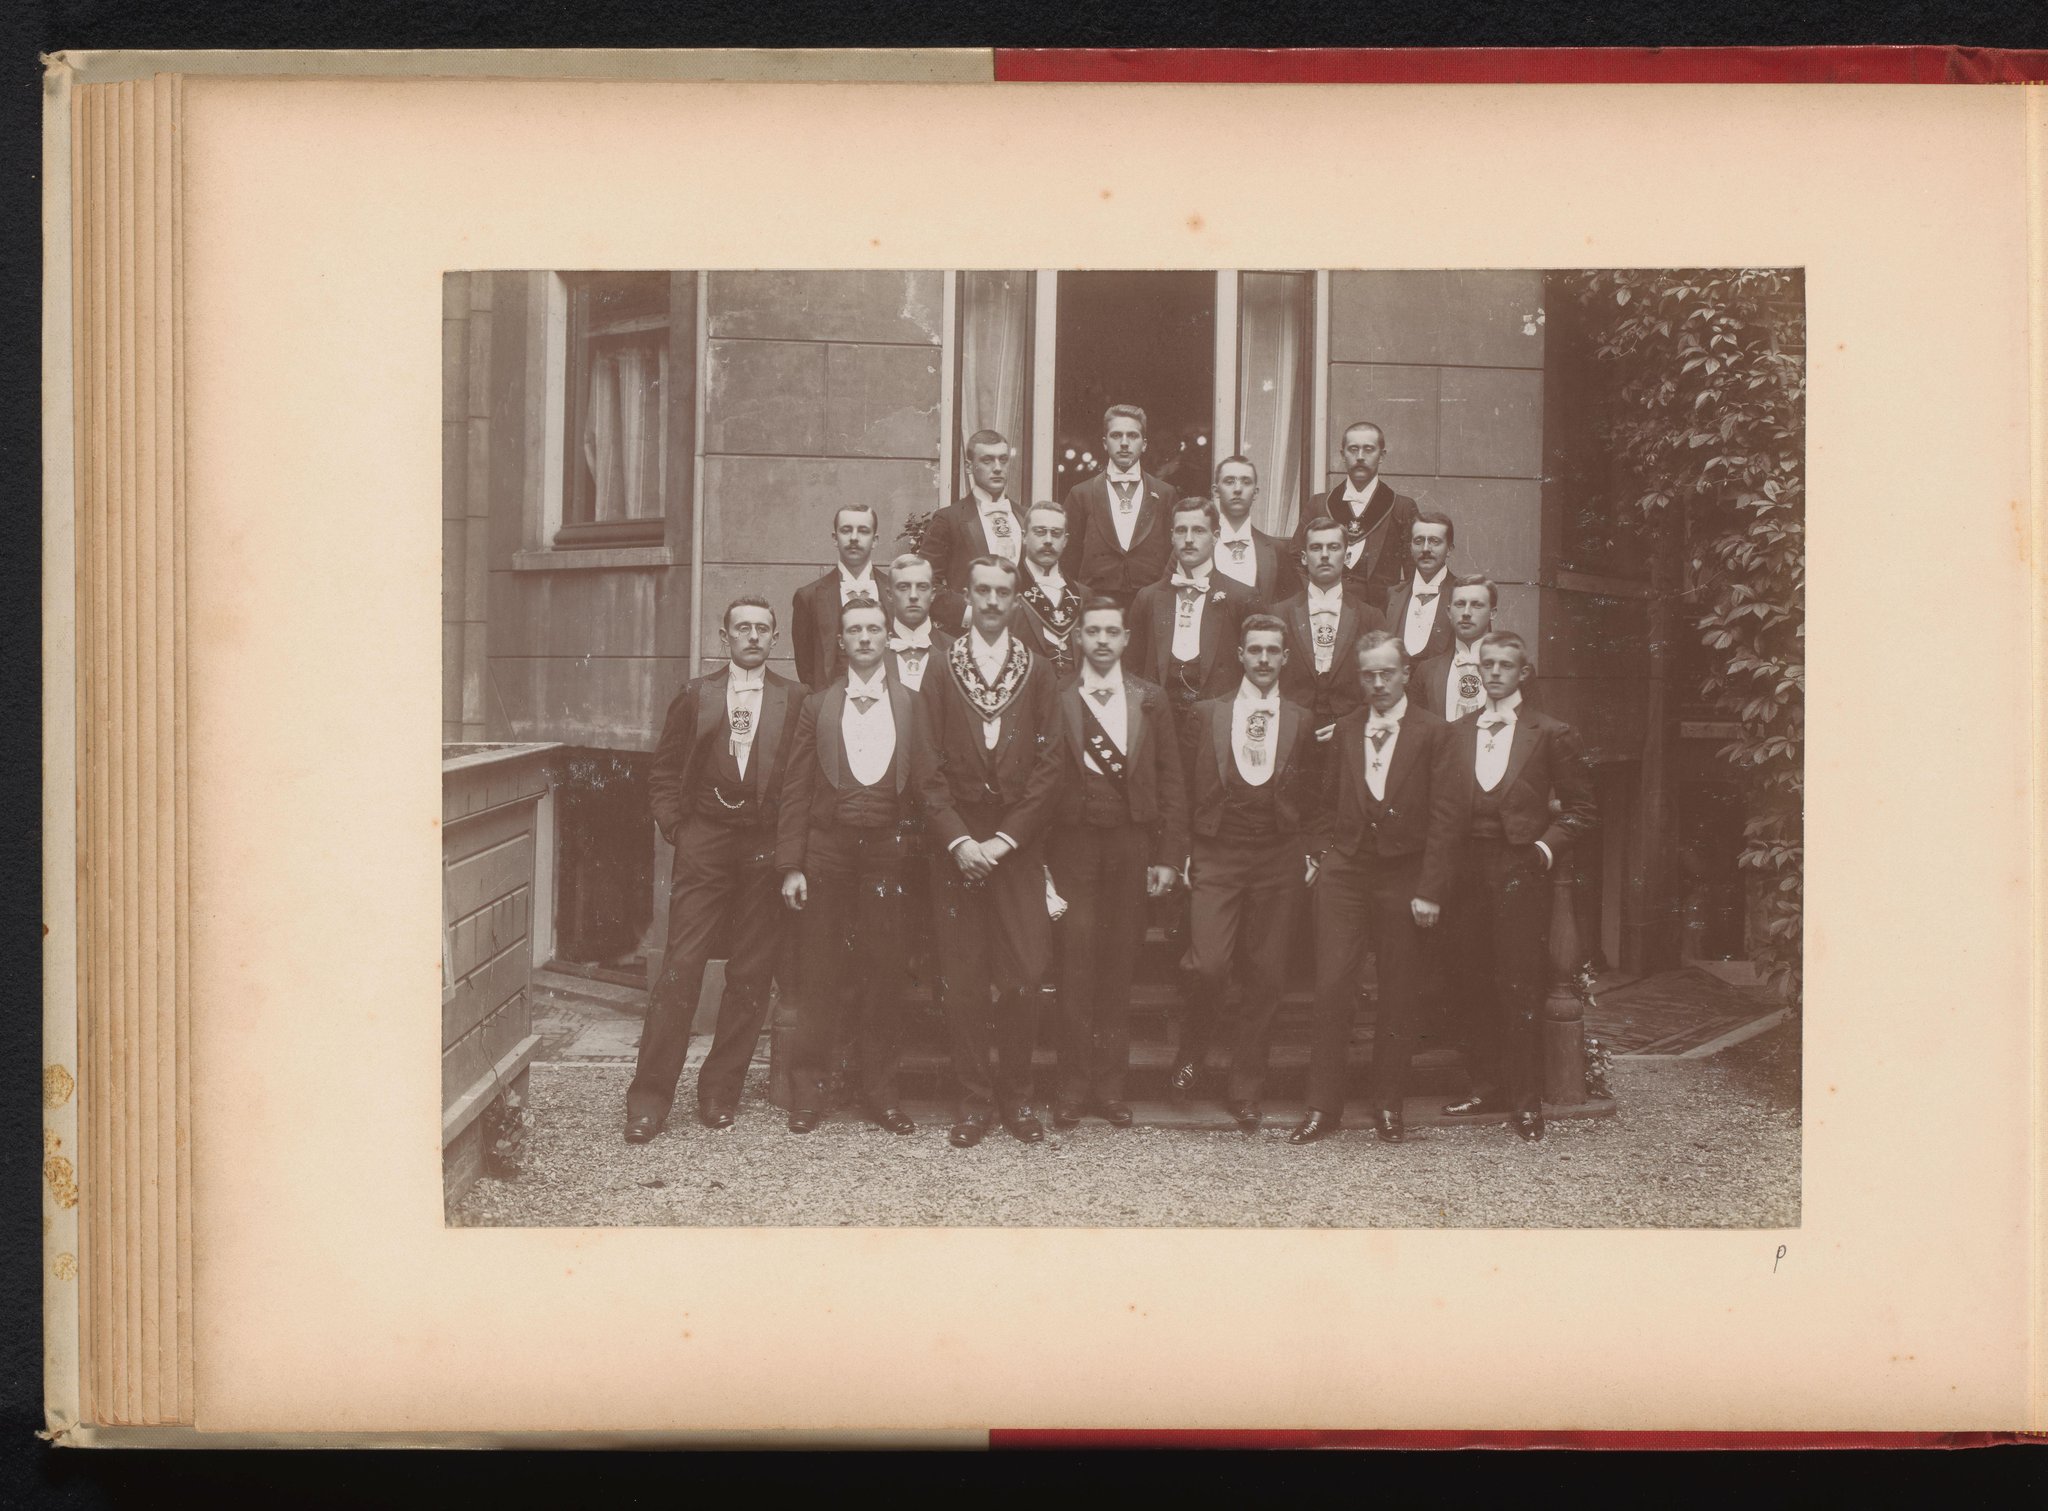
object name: album leaf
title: Groepsportret van leden van het Amsterdamsch Studenten Corps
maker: nicolaas schuitvlot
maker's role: fotograaf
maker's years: 1859-1947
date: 1806-1897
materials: cardboard, photographic support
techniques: collodion silver print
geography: netherlands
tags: students' organization, anonymous historical persons portrayed in a group, in a group-portrait, netherlands